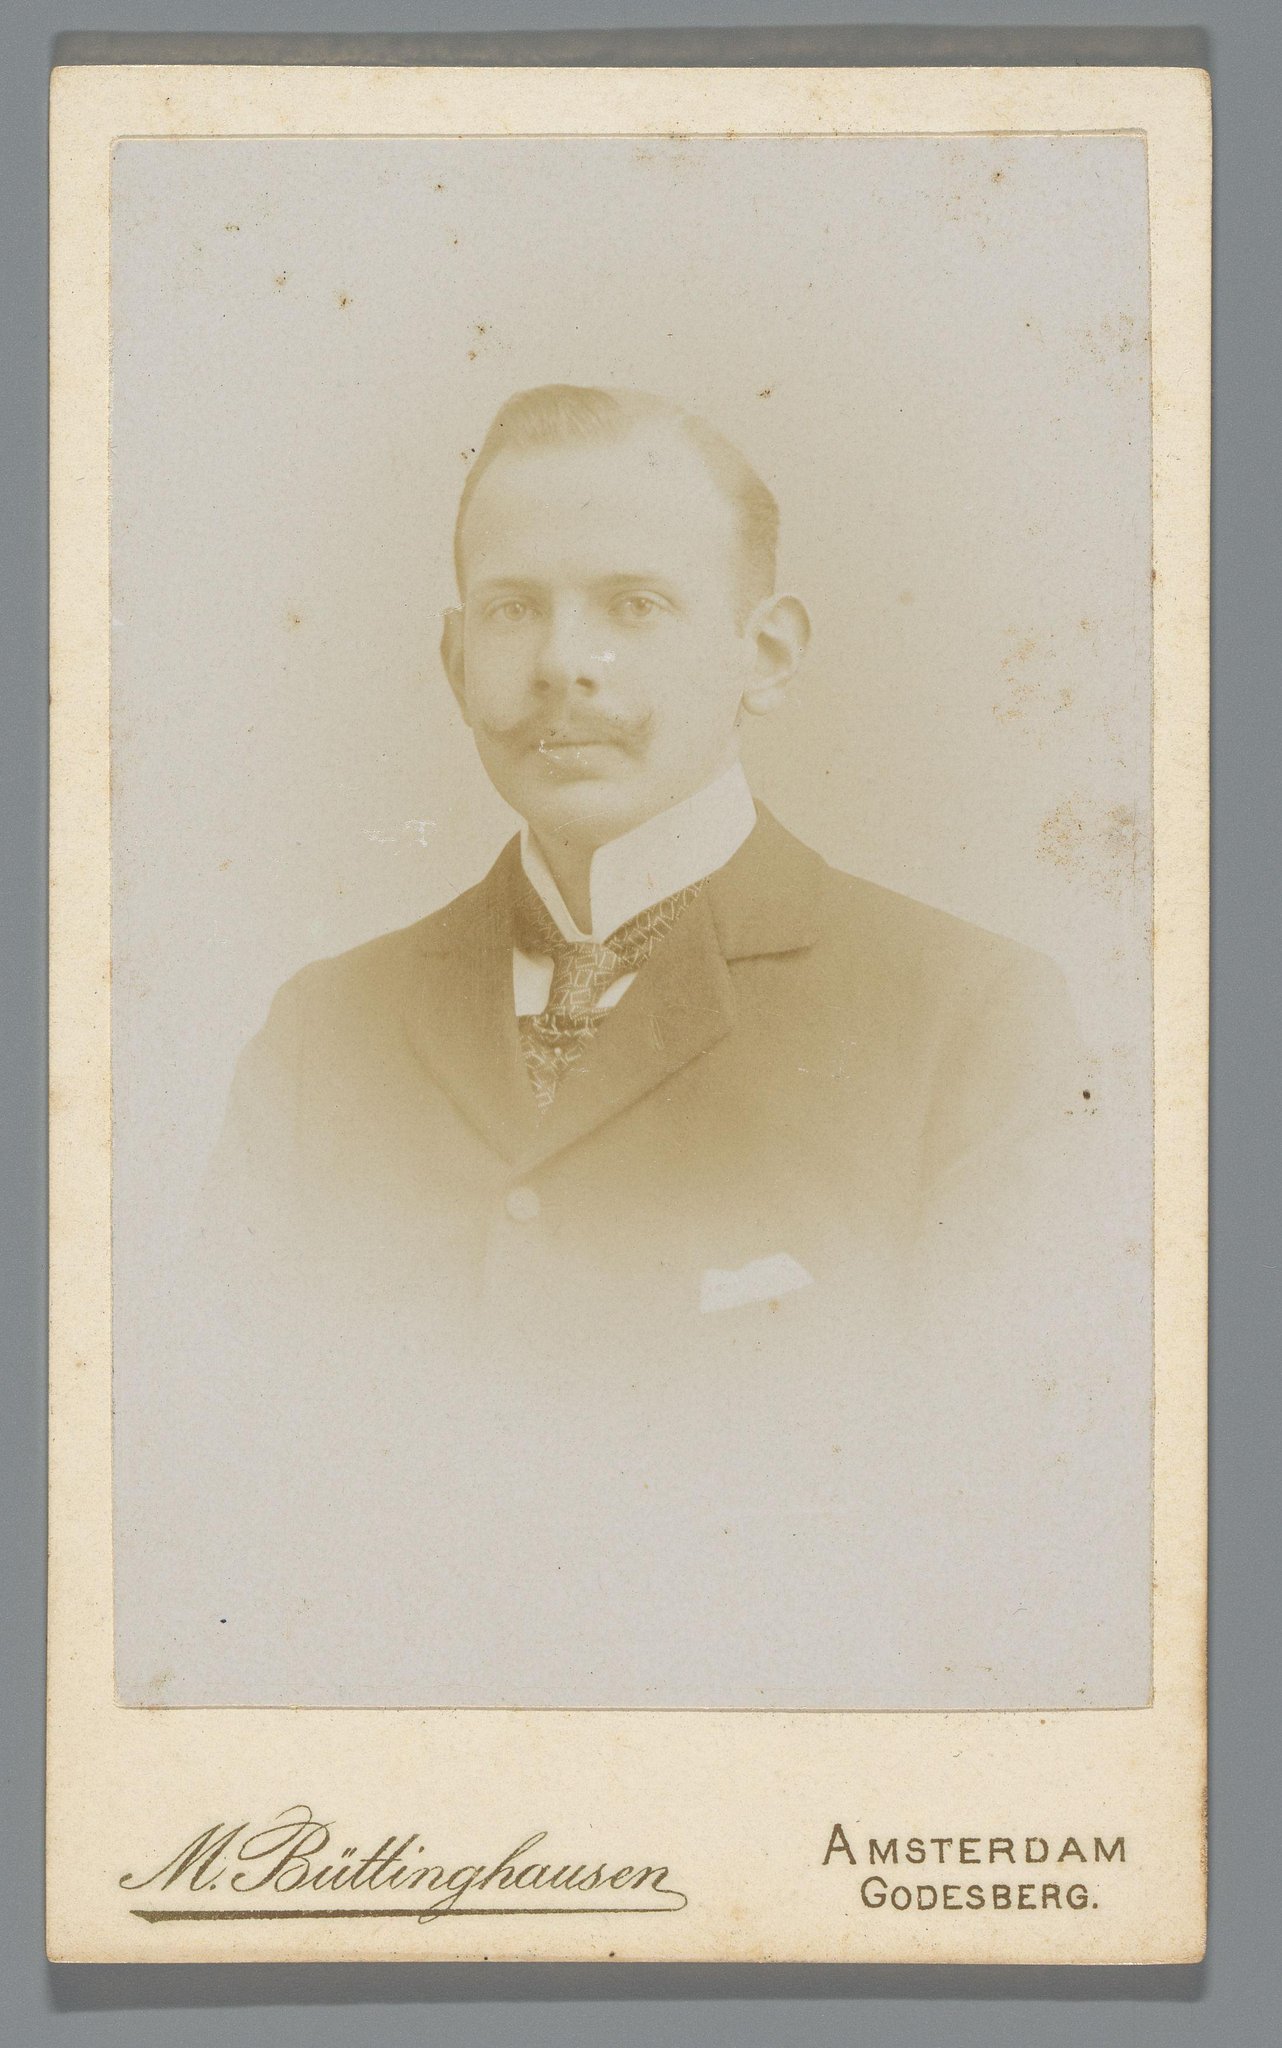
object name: carte de visite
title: Portret van Karel Frederik van den Berg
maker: max büttinghausen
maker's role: fotograaf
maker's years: 1847-1906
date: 1900-1910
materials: cardboard, photographic support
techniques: albumen print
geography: amsterdam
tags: batavia, karel frederik van den berg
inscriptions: inscription: ‘M. Büttinghausen / AMSTERDAM / GODESBERG’, name: ‘K.F. van den Berg’